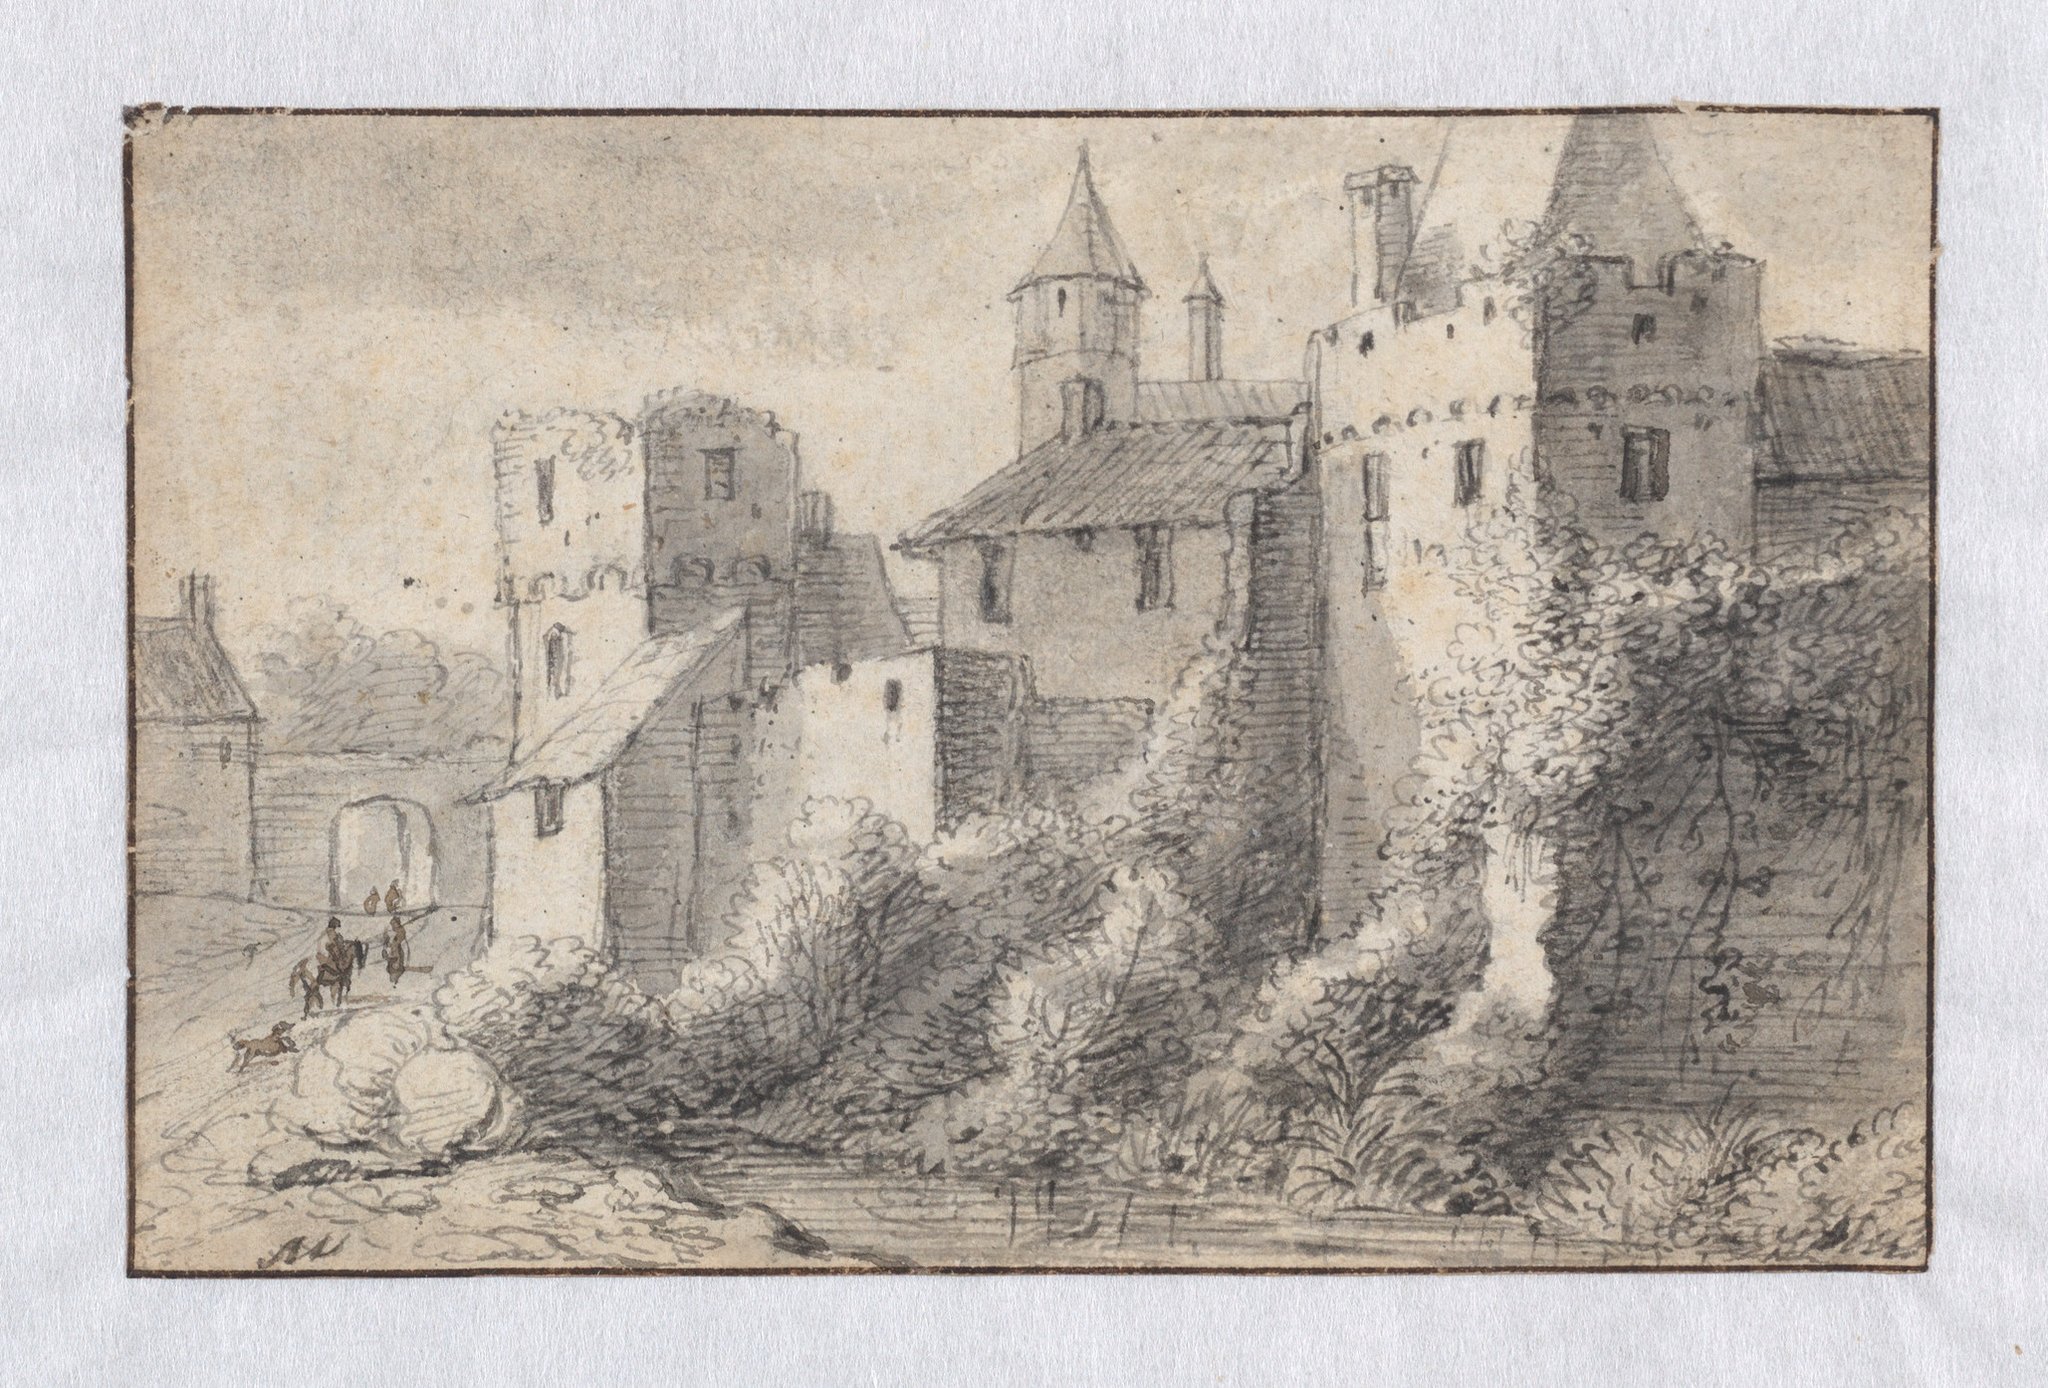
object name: drawing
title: The Winsertor on the Messberg Hamburg (recto); View of the City Walls of Hamburg (verso)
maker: anthonie waterloo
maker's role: artist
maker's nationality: dutch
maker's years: 1609-1690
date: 1658-1660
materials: chalk, ink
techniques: brush, pen, wash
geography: netherlands